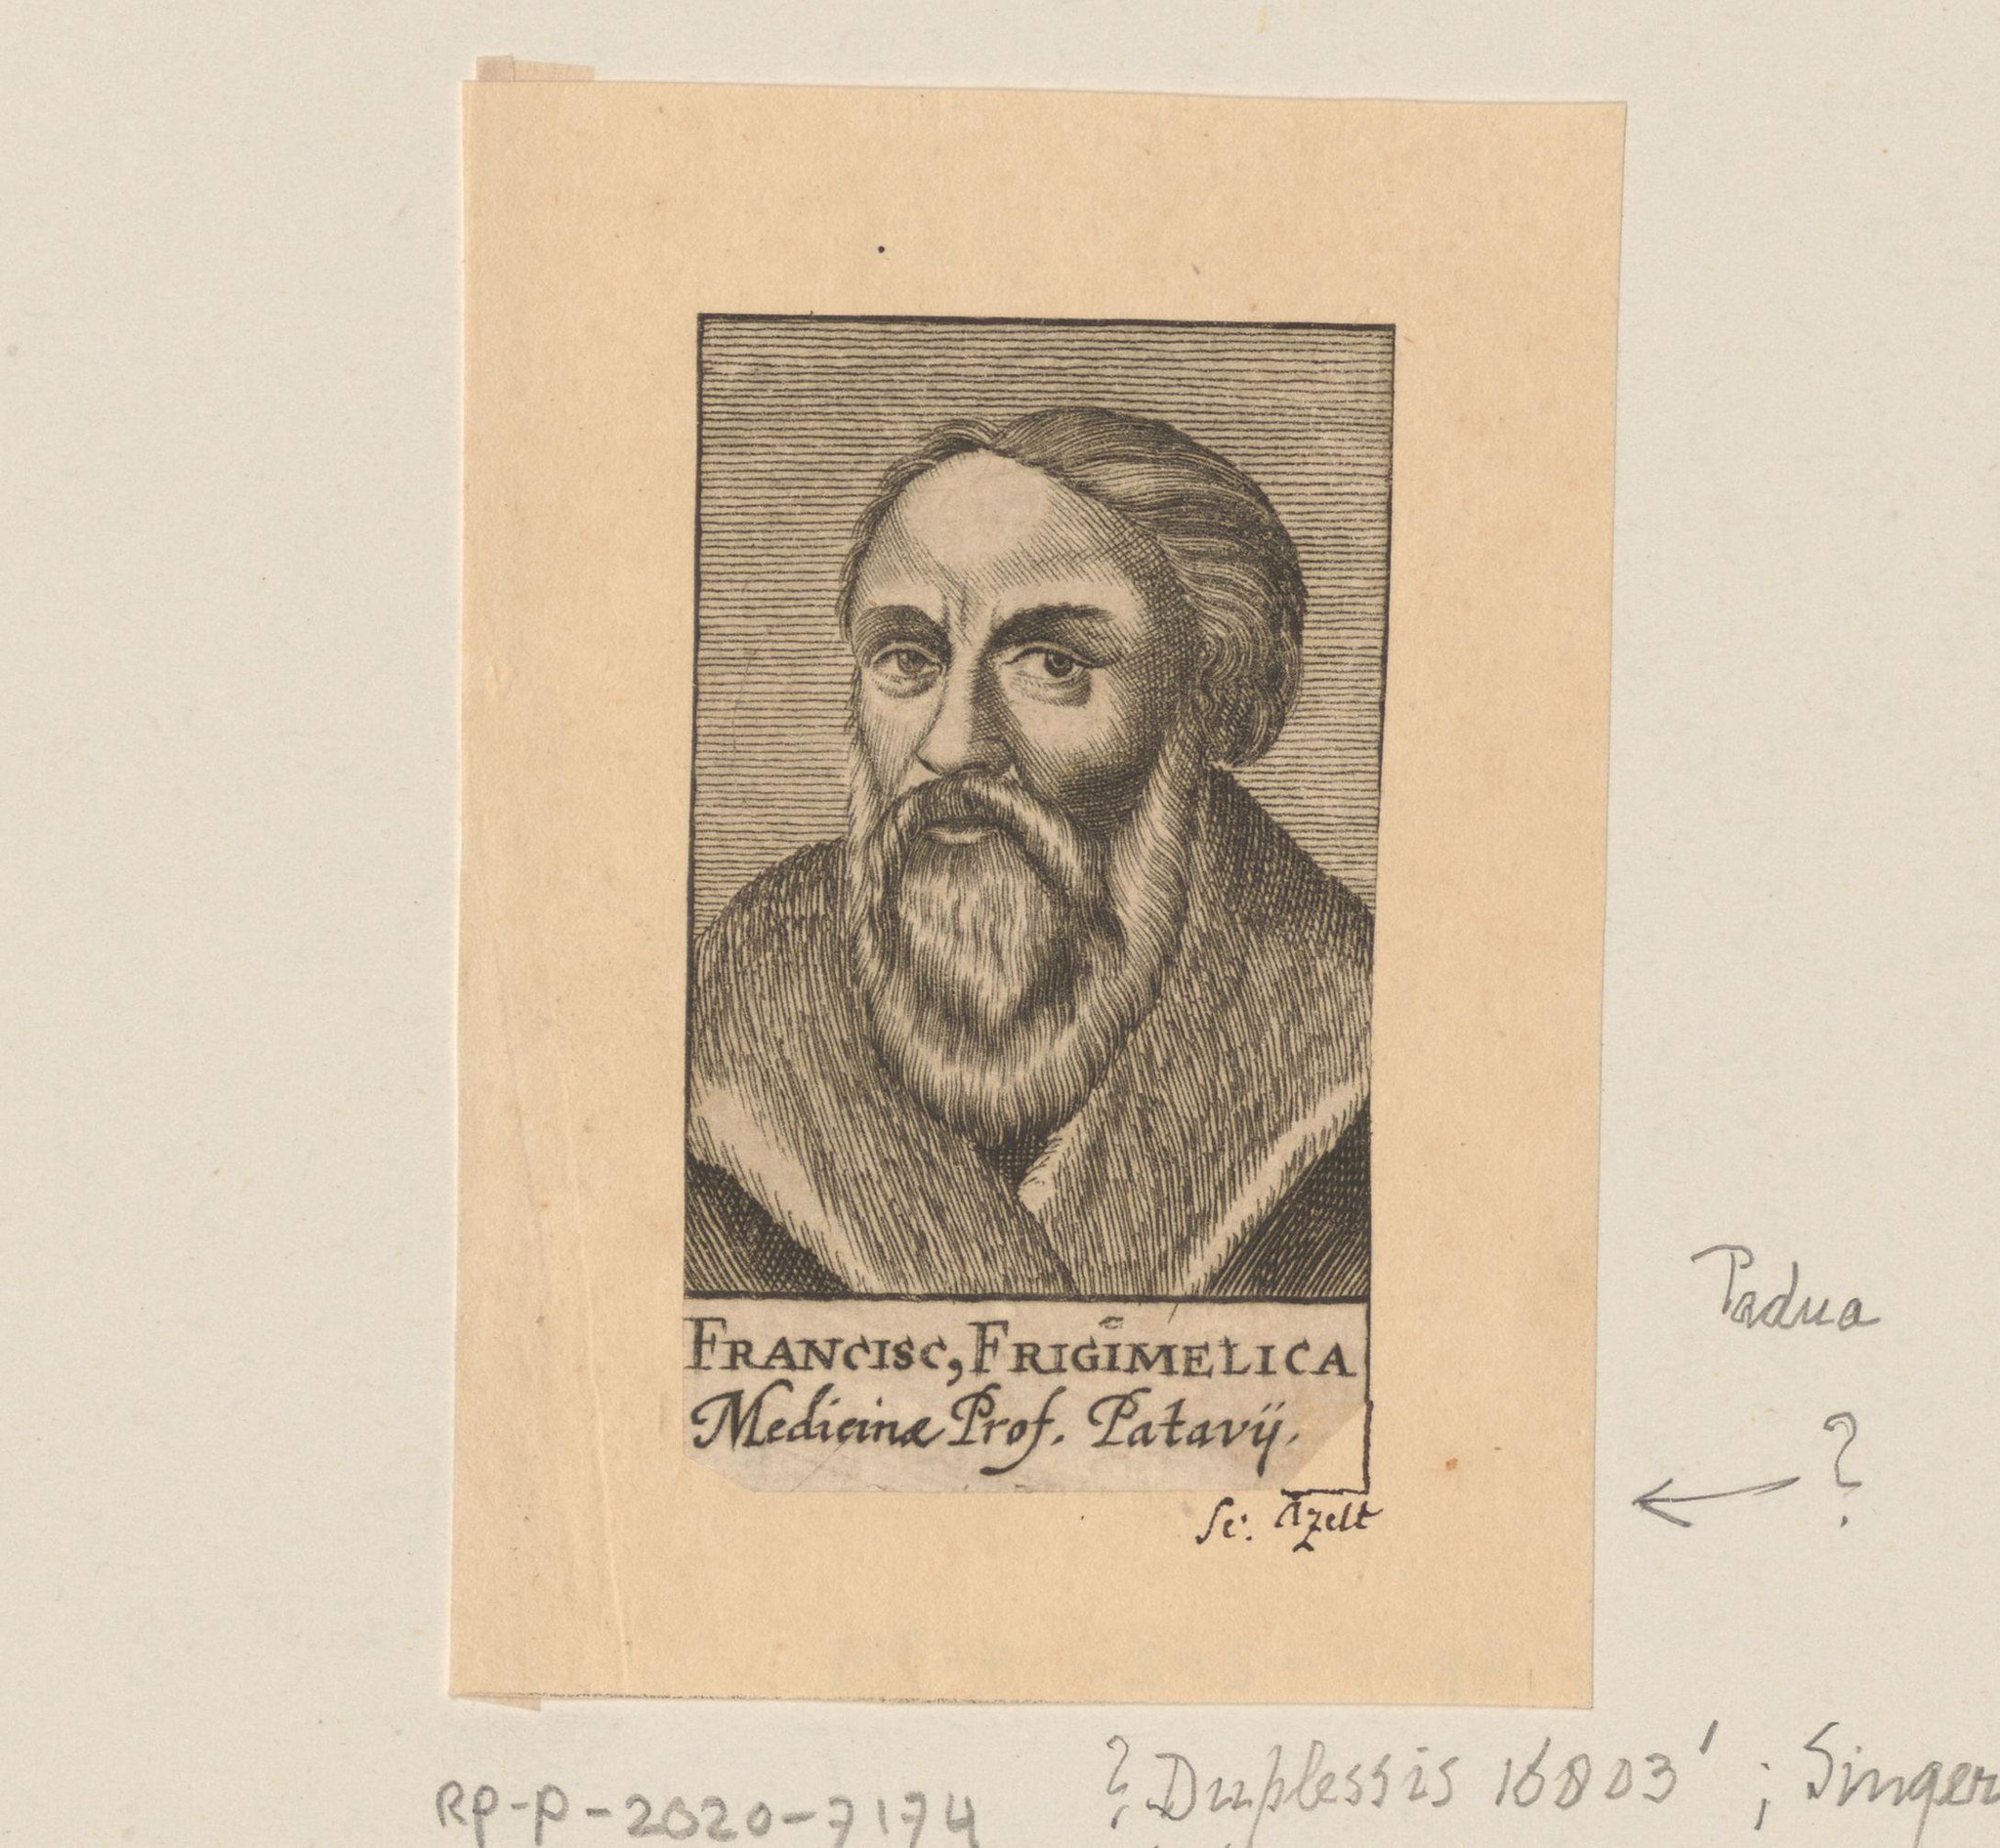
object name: print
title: Portret van Francesco Frigimelica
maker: johann azelt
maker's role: print maker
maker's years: 1654-1692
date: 1688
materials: paper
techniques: engraving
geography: germany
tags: historical persons, physician, doctor (+ portrait of scholar, scientist)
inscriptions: inscription: ‘Sc: Azelt’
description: Prent waarschijnlijk uit: Freher, Paul. Theatrum virorum eruditione clarorum. Neurenberg: Johann Hoffmann, 1688.